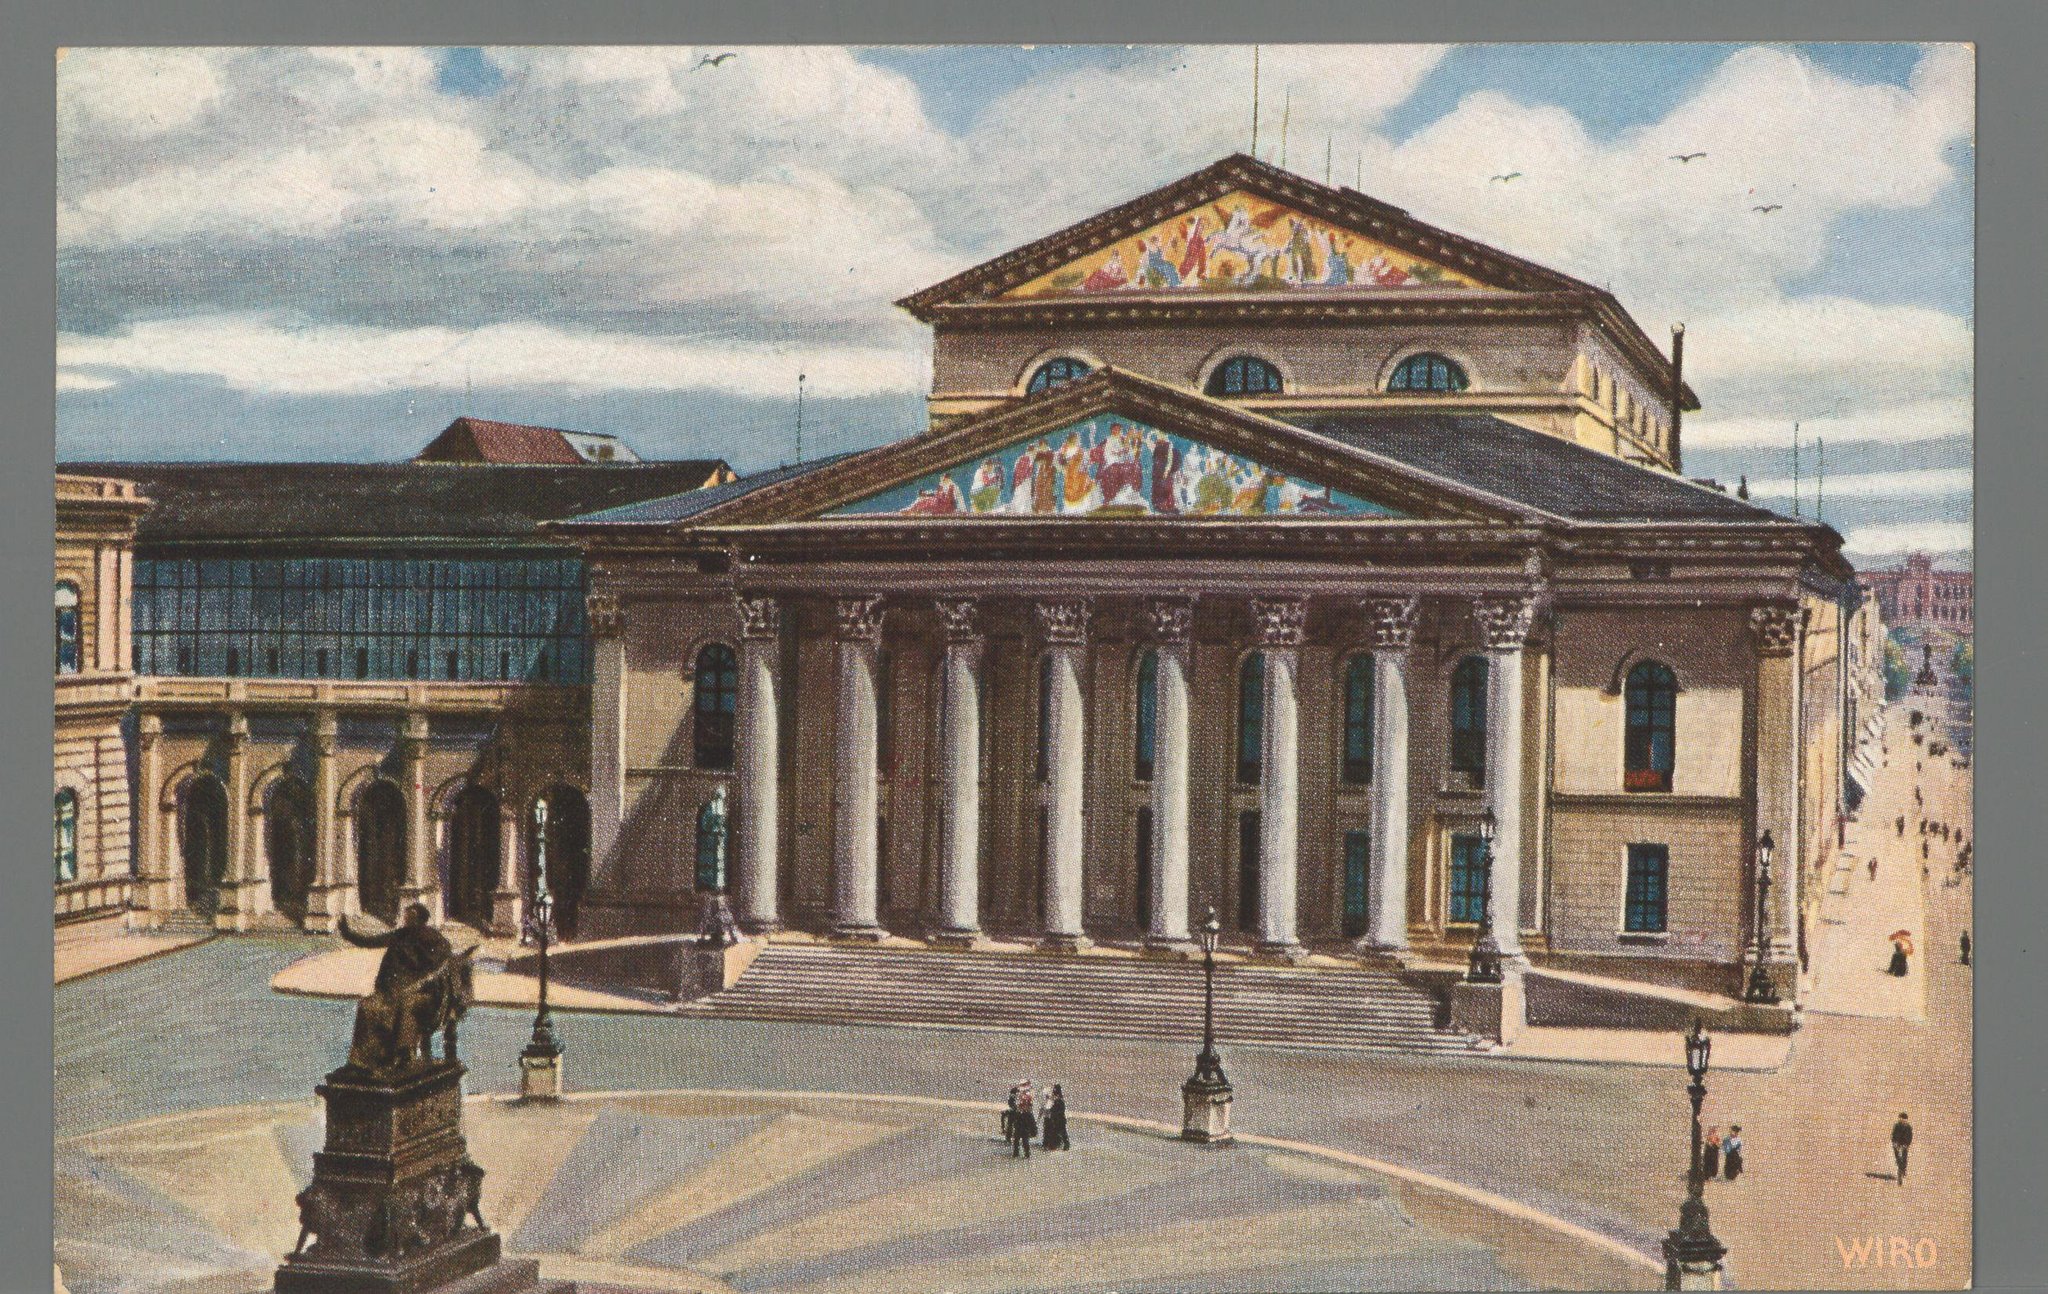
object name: photomechanical print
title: Künstler-Serie "WIRO" München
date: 1905-1930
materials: cardboard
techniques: color autotype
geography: munich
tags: theatre (building), monument, statue